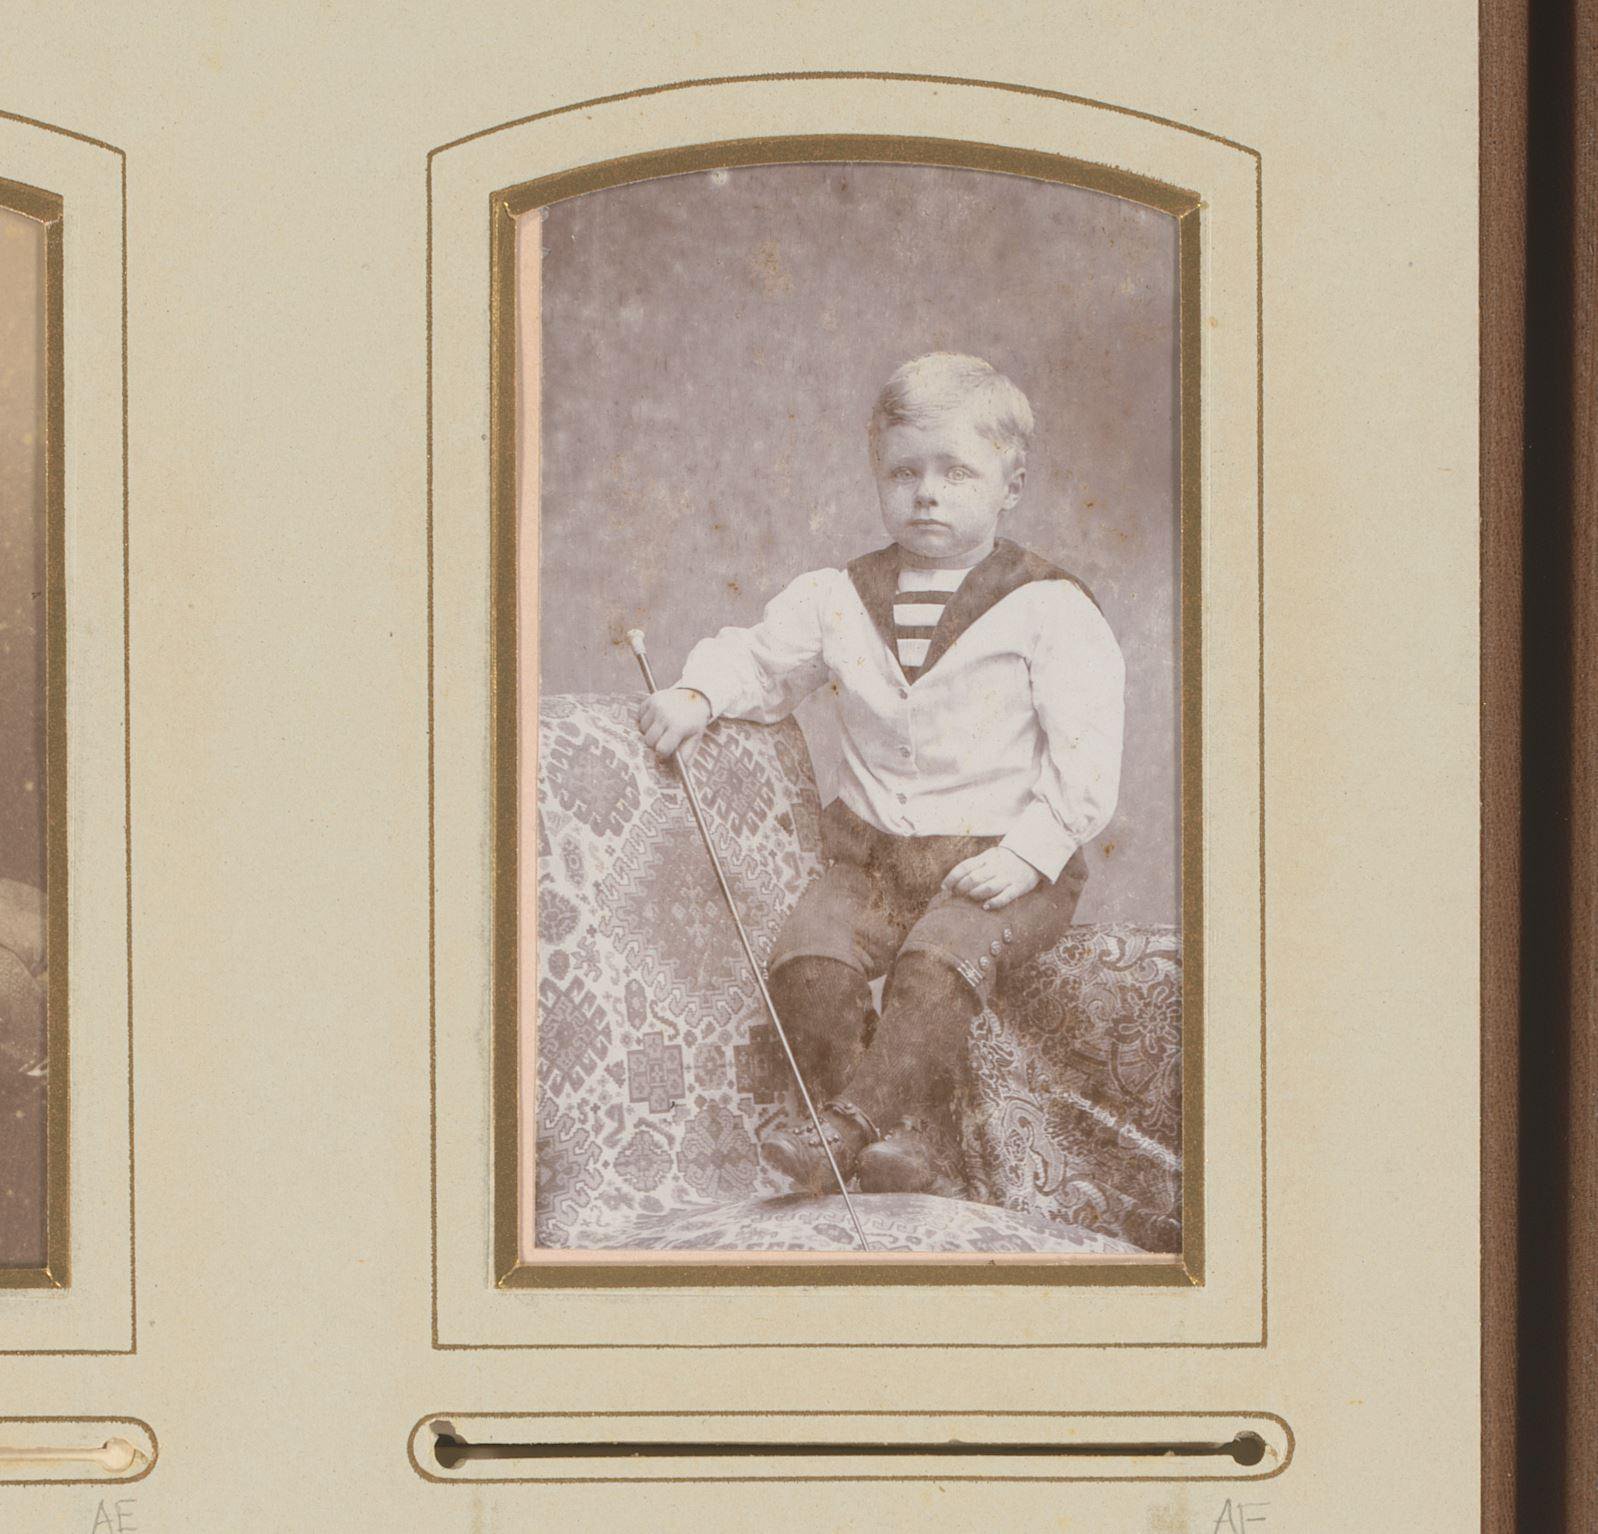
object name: photograph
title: Portret van een zittende jongen in matrozenpak met zweep in de hand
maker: friedrich julius von kolkow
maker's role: fotograaf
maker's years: 1839-1914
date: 1880-1913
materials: cardboard, photographic support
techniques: collodion silver print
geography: groningen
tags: ensemble of pieces of clothing: sailor suit, historical persons, toddler (male), whip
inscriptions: inscription: ‘(...)/ Fr. Jul von Kolkow/ Koninklyk Nederlandsch Hof-Photograph/ (...)/ GRONINGEN/ Groote Markt by de/ Martinitoorn./ Specialiteit in Vergrootingen.’